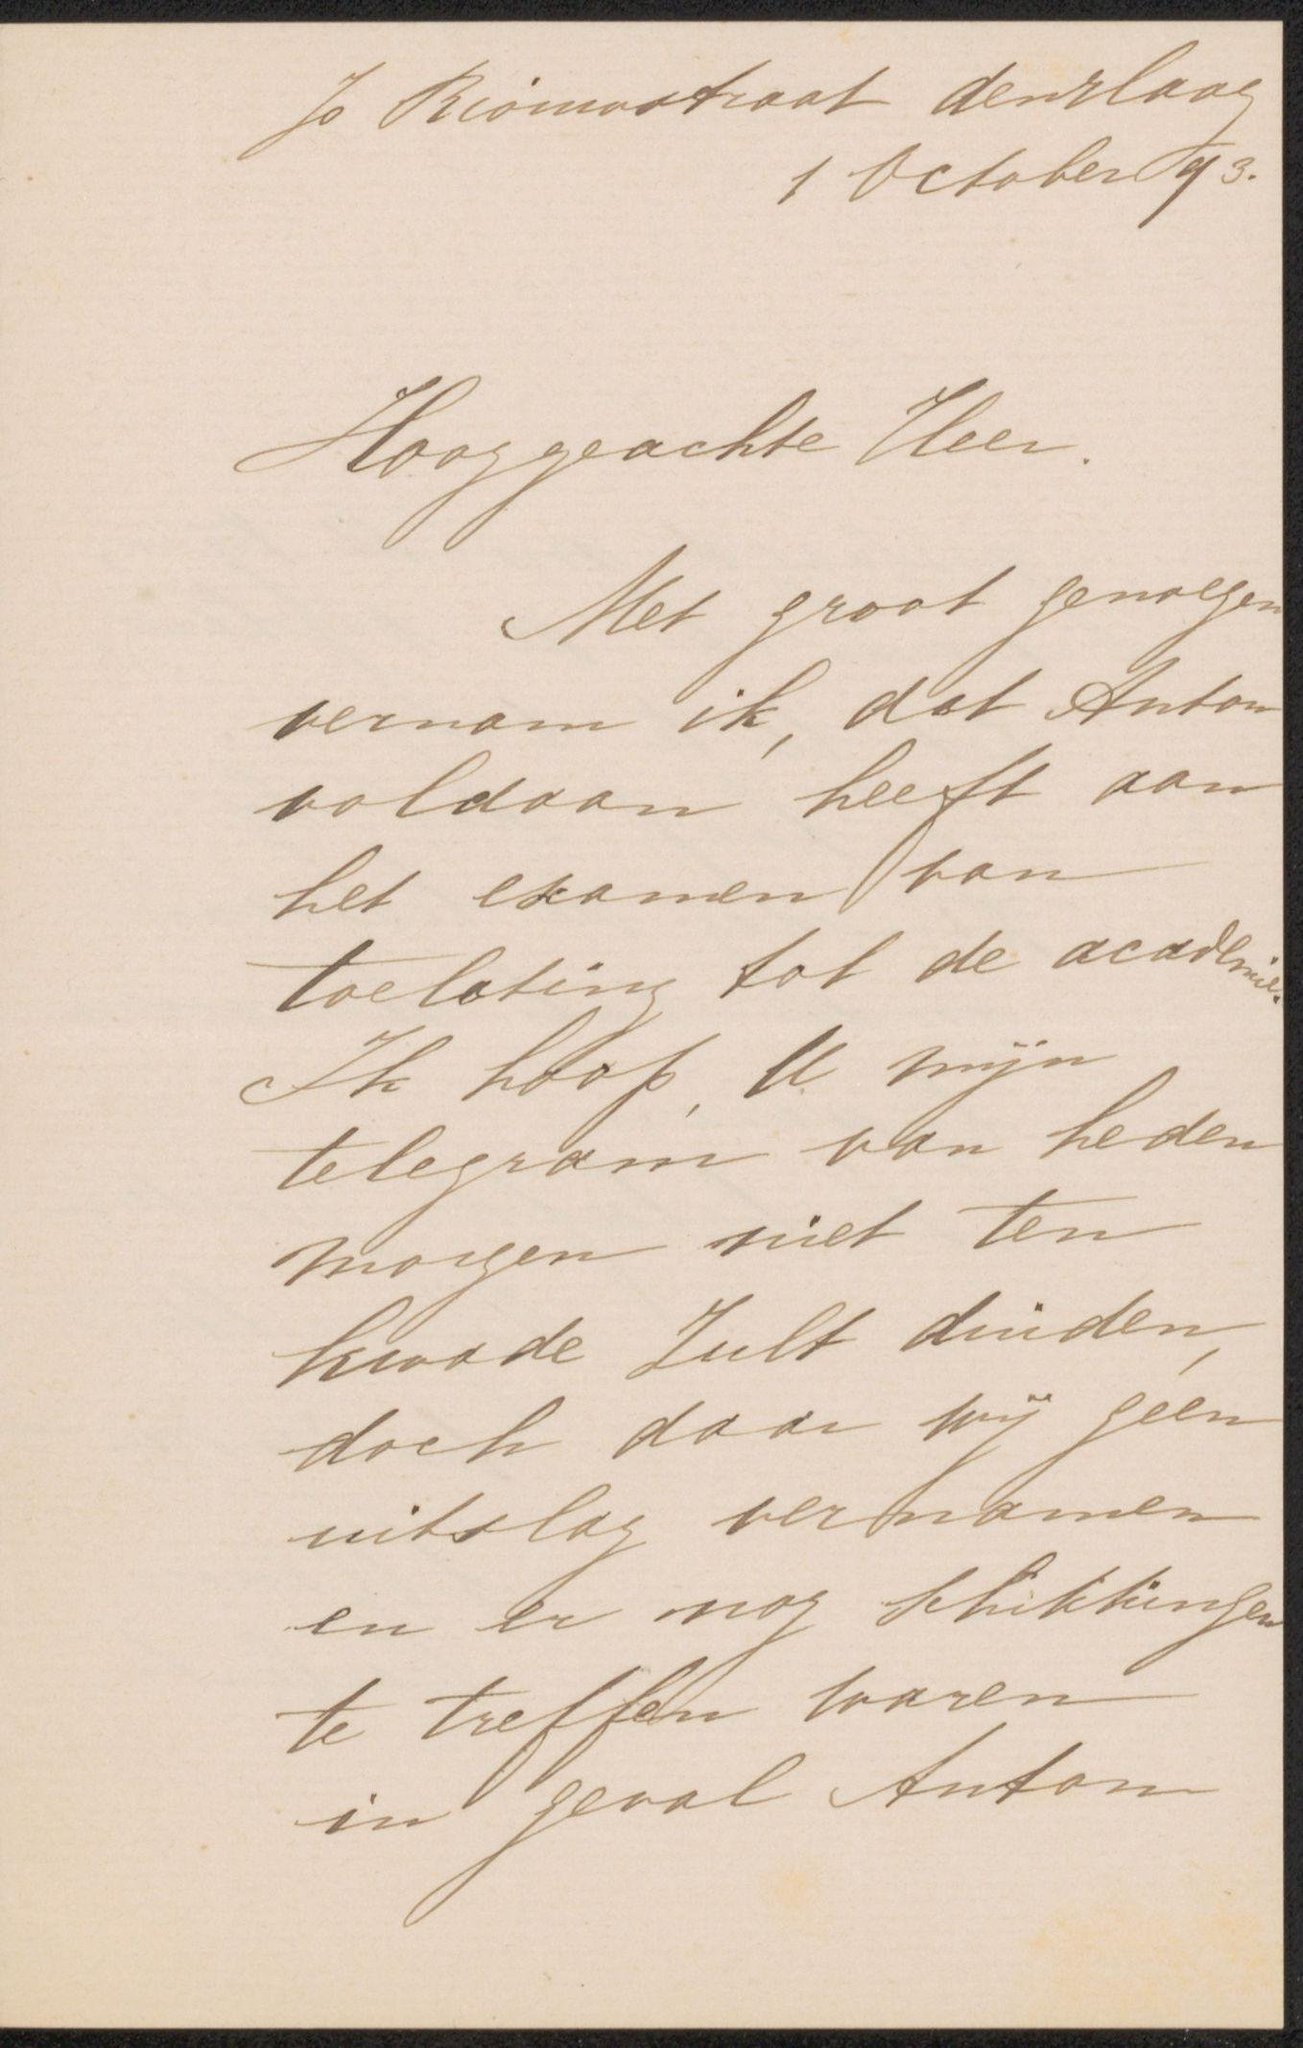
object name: letter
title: Brief aan August Allebé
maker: ariette sophia jeannette mauve-carbentus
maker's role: draughtsman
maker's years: 1856-1894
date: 1893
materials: ink, paper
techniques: pen, writing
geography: the hague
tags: amsterdam, print maker, august allebé, the hague, draughtsman, anton rudolf mauve, education, tuition of the artist (in general)